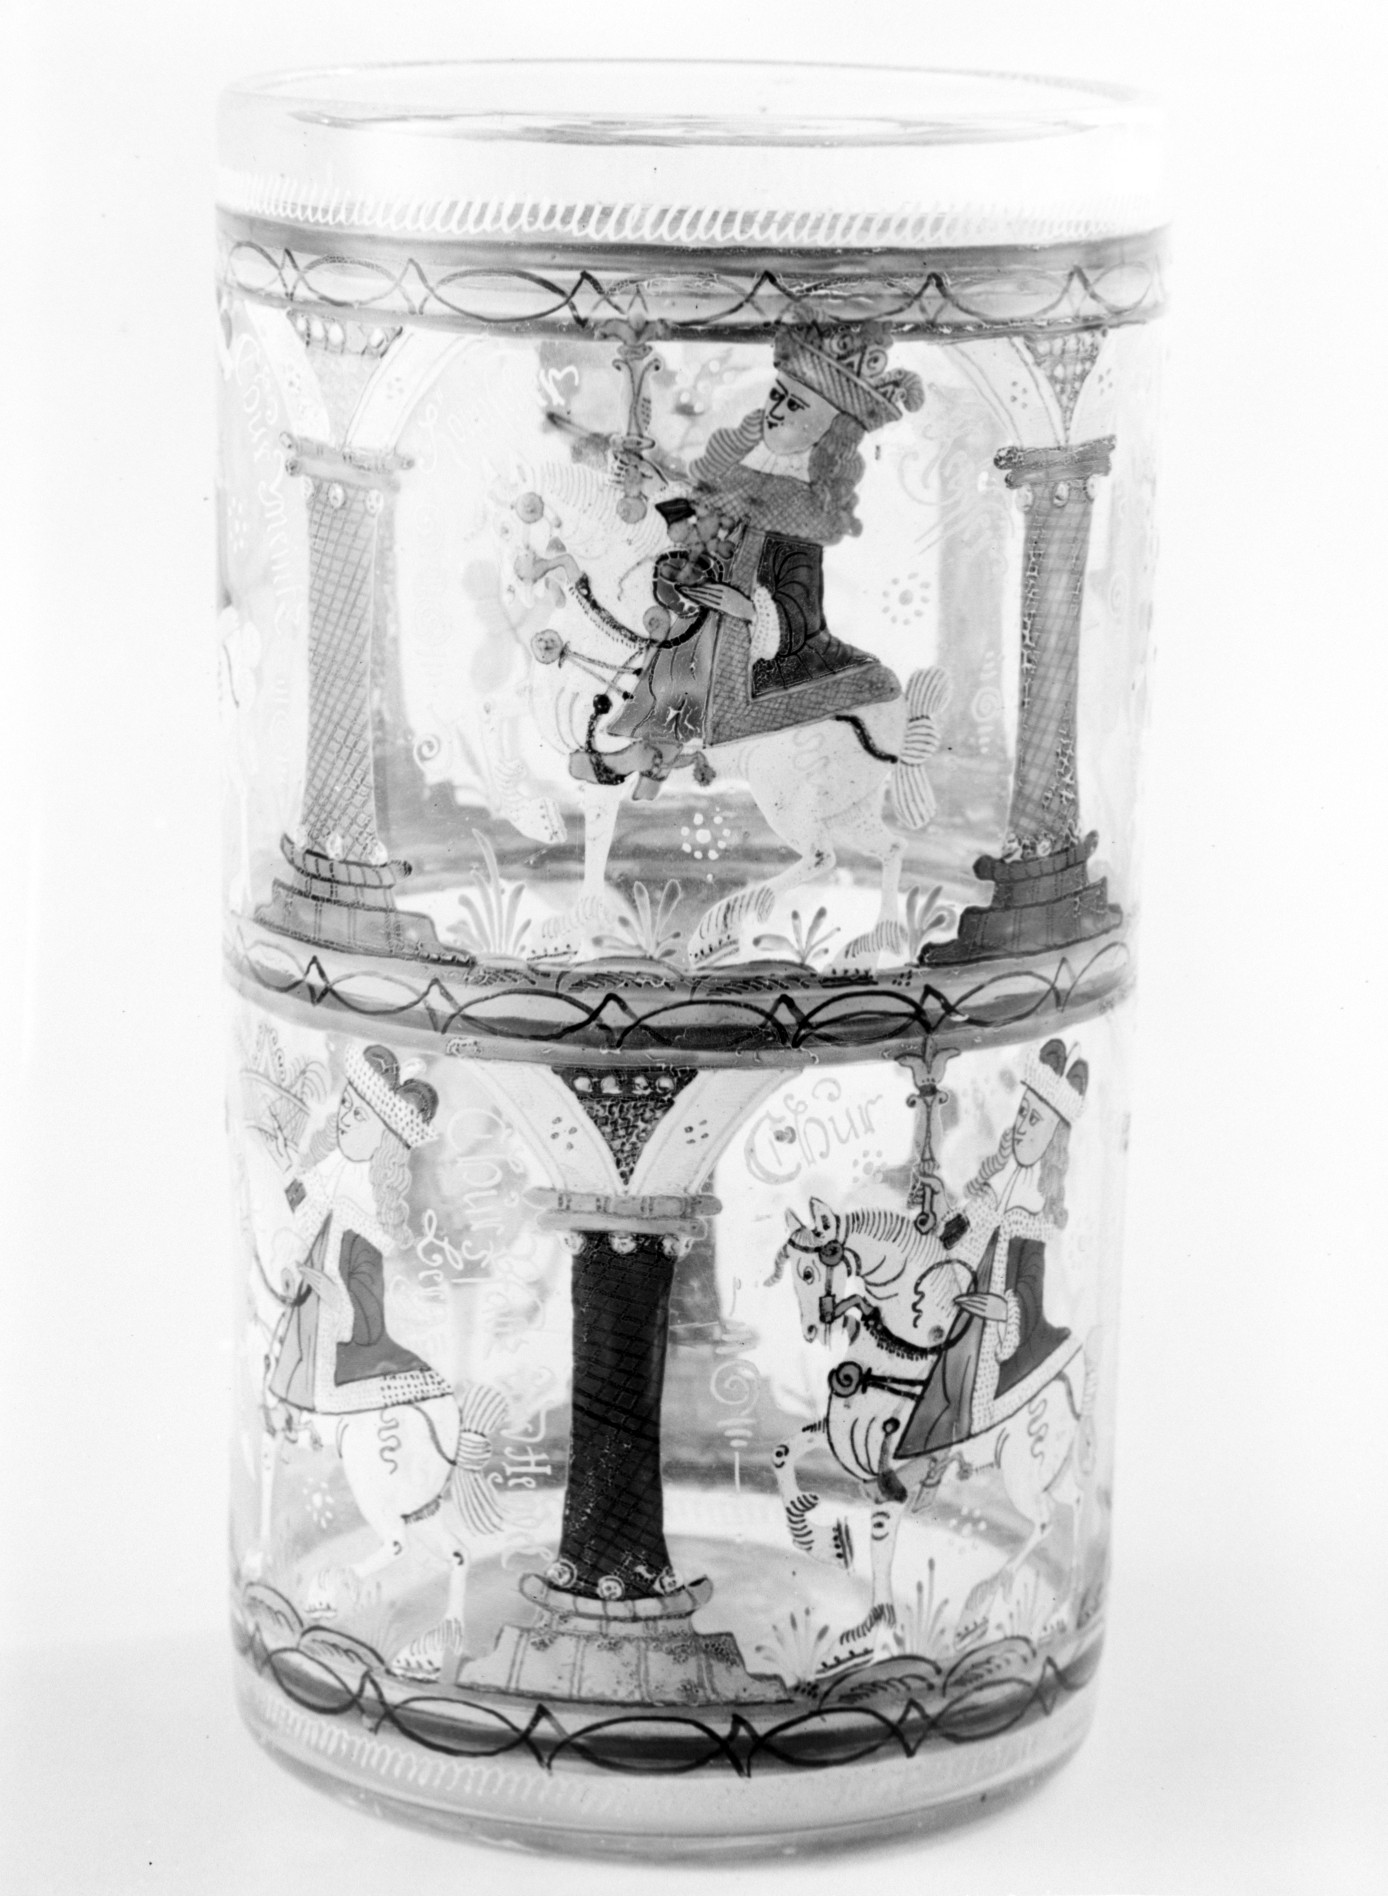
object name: kurfursten humpen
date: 1651-1700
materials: glass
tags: horses